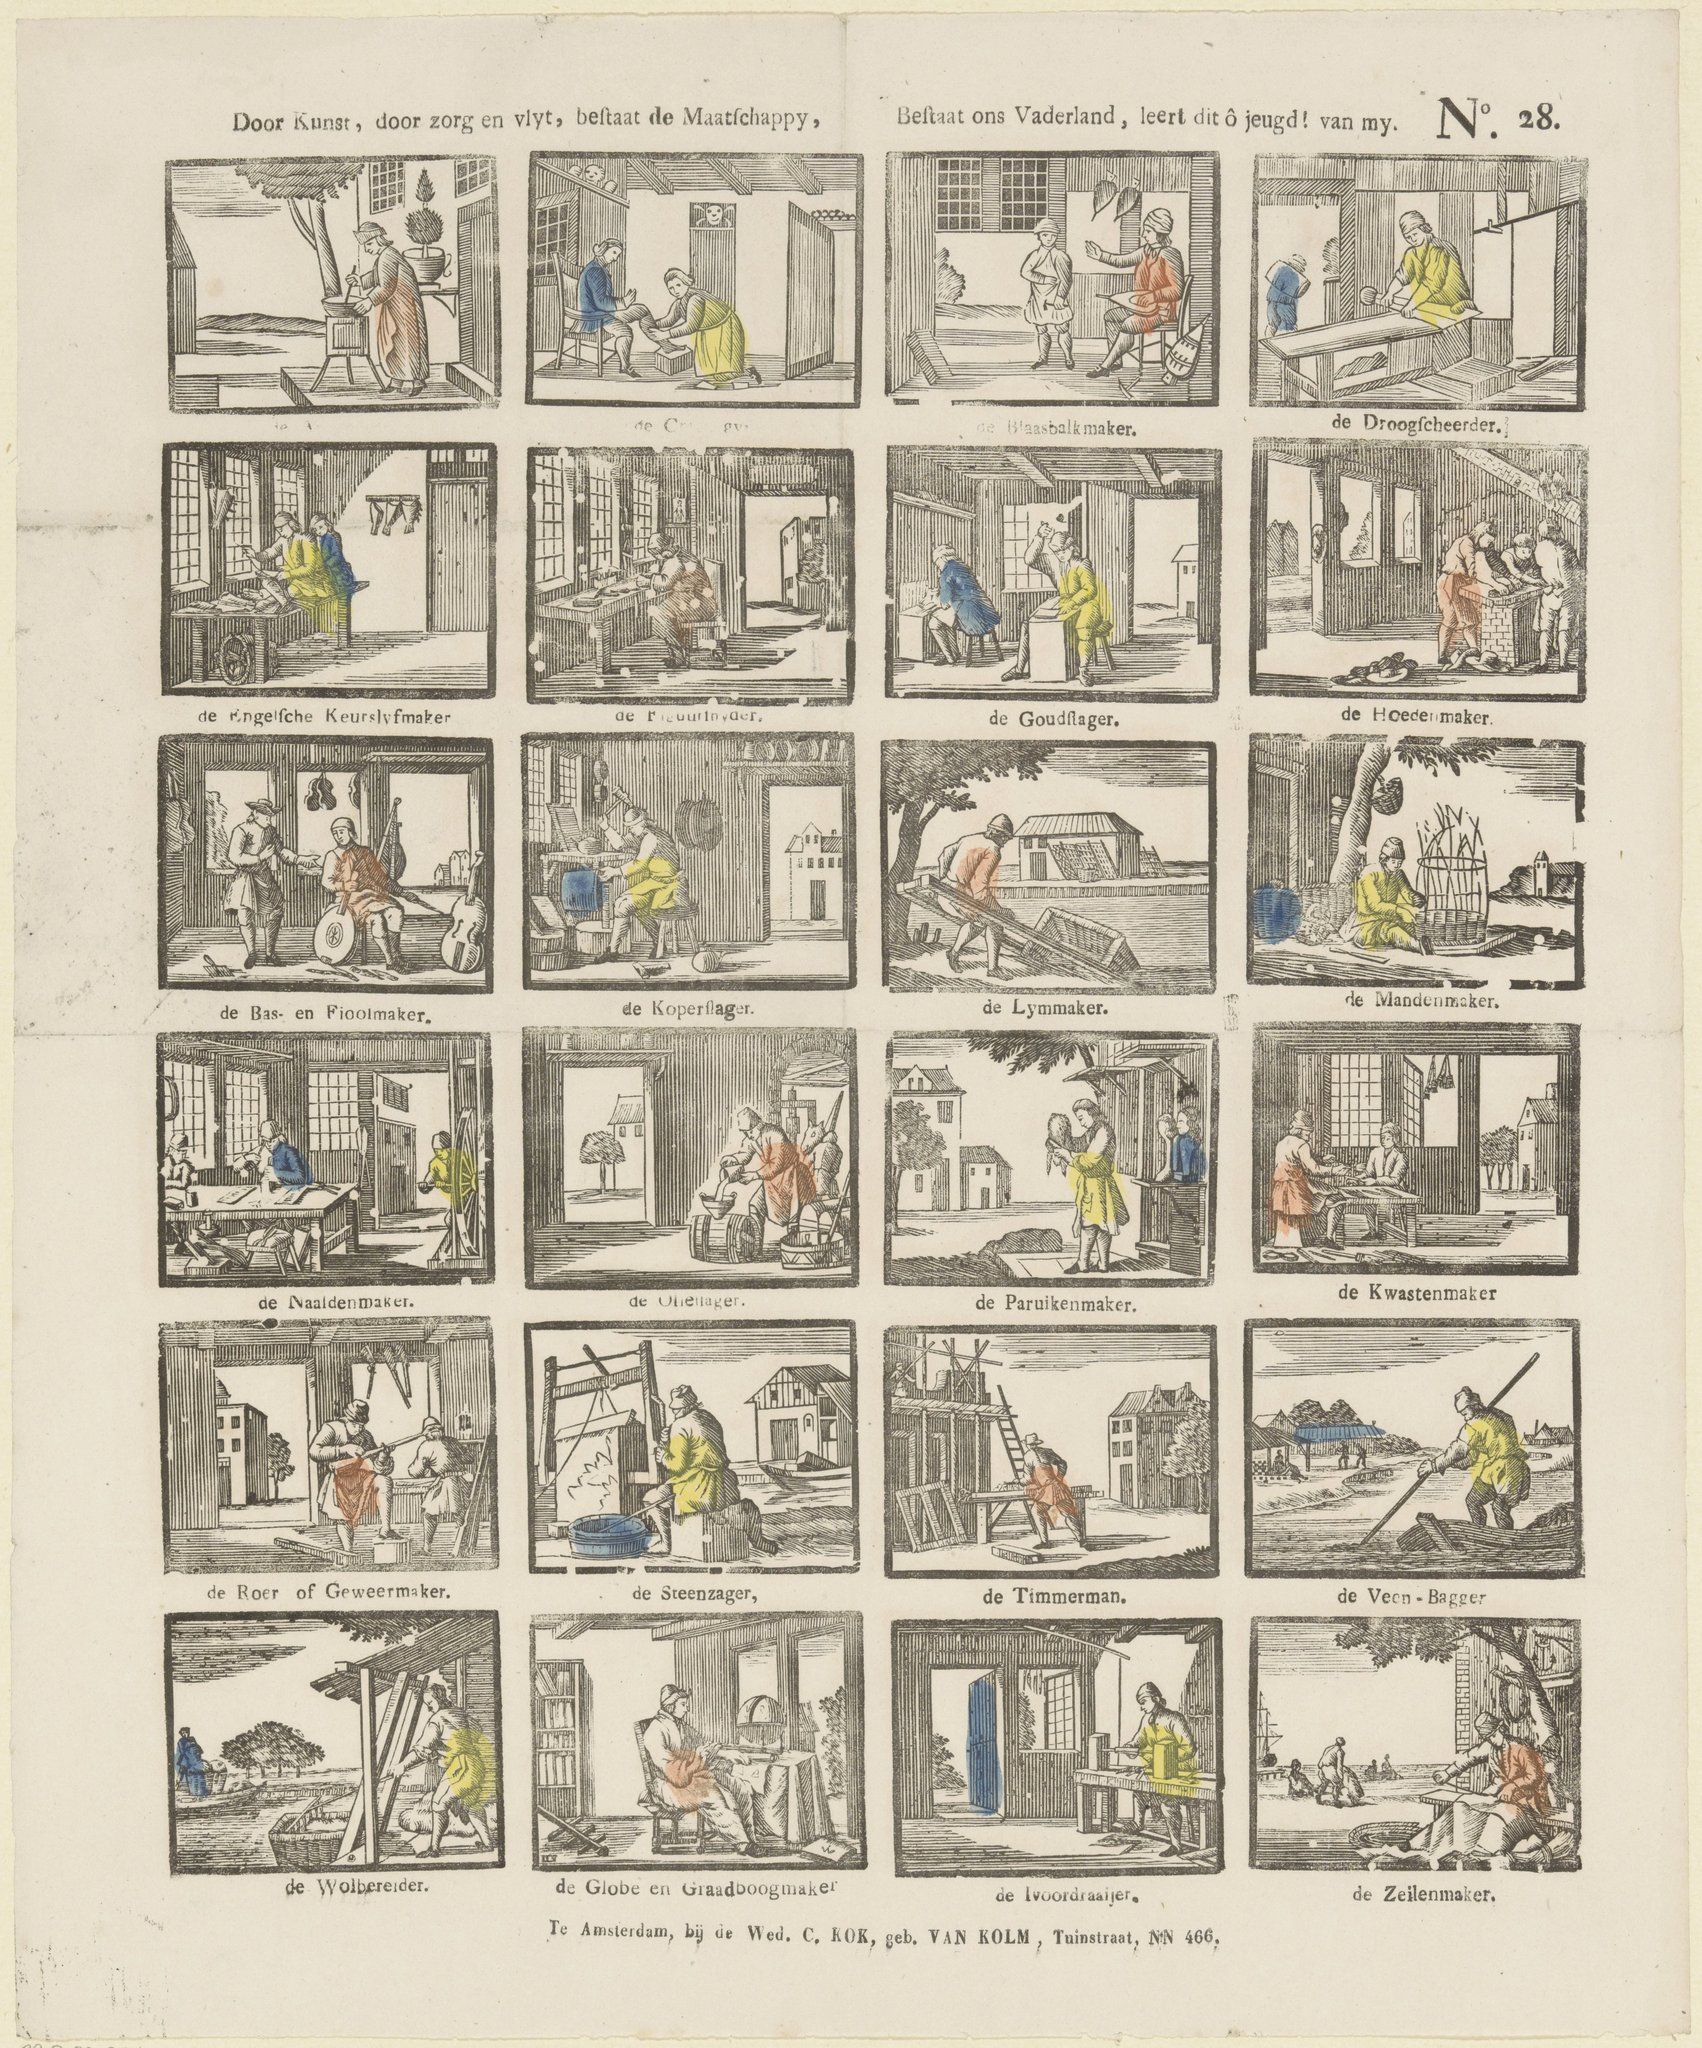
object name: popular print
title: Door Kunst, door zorg en vlyt, bestaat de maatschappy, Bestaat ons vaderland, leert dit ô jeugd! van my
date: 1842-1866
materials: paper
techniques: colour, letterpress printing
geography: netherlands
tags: carpenter, craft-production, skilled handiwork, pharmacist, druggist, apothecary; pharmacy, drugstore, dispensing chemist, crafts and industries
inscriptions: collector's mark: Lugt 2760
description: Blad met 24 voorstellingen van ambachtslieden en beroepen, zoals apotheker, hoedenmaker en timmerman. Onder elke afbeelding een onderschrift. Genummerd rechtsboven: No. 28.